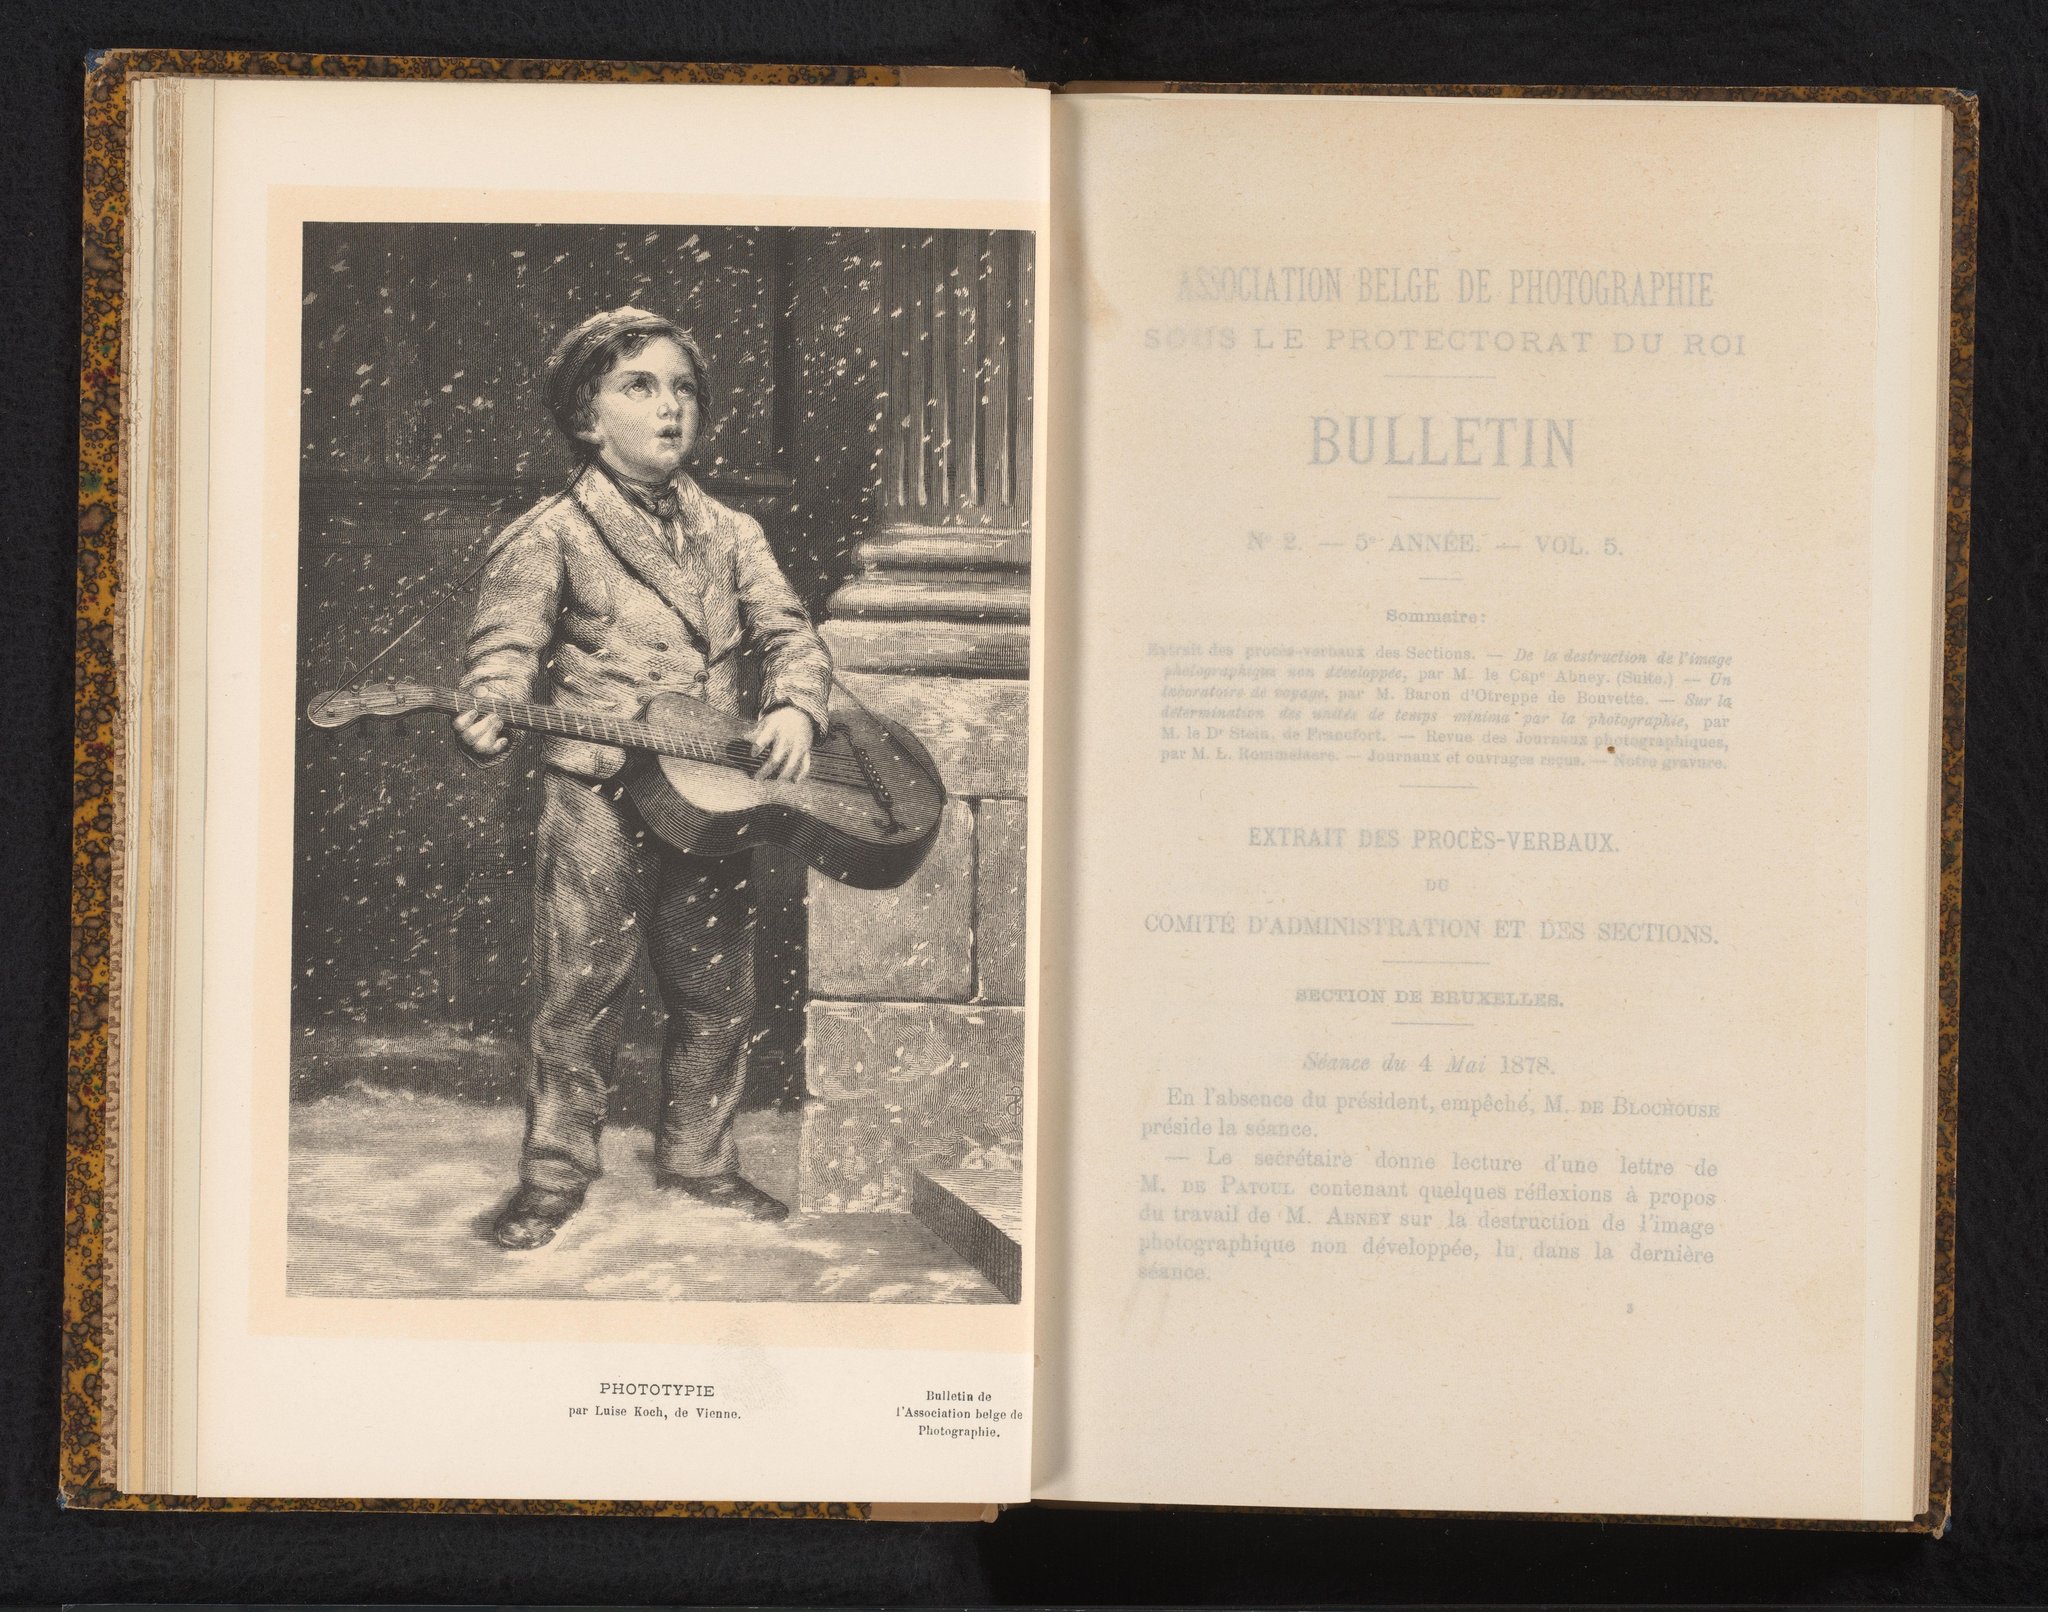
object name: page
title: Watermolen van Halleux aan de Amblève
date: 1874-1879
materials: paper, cardboard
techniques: photograph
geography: halleux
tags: watermill, watermill in landscape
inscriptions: inscription: ‘Émulsion de M. Warnerke, de Londres,/ médaillée au concours de 1878.’